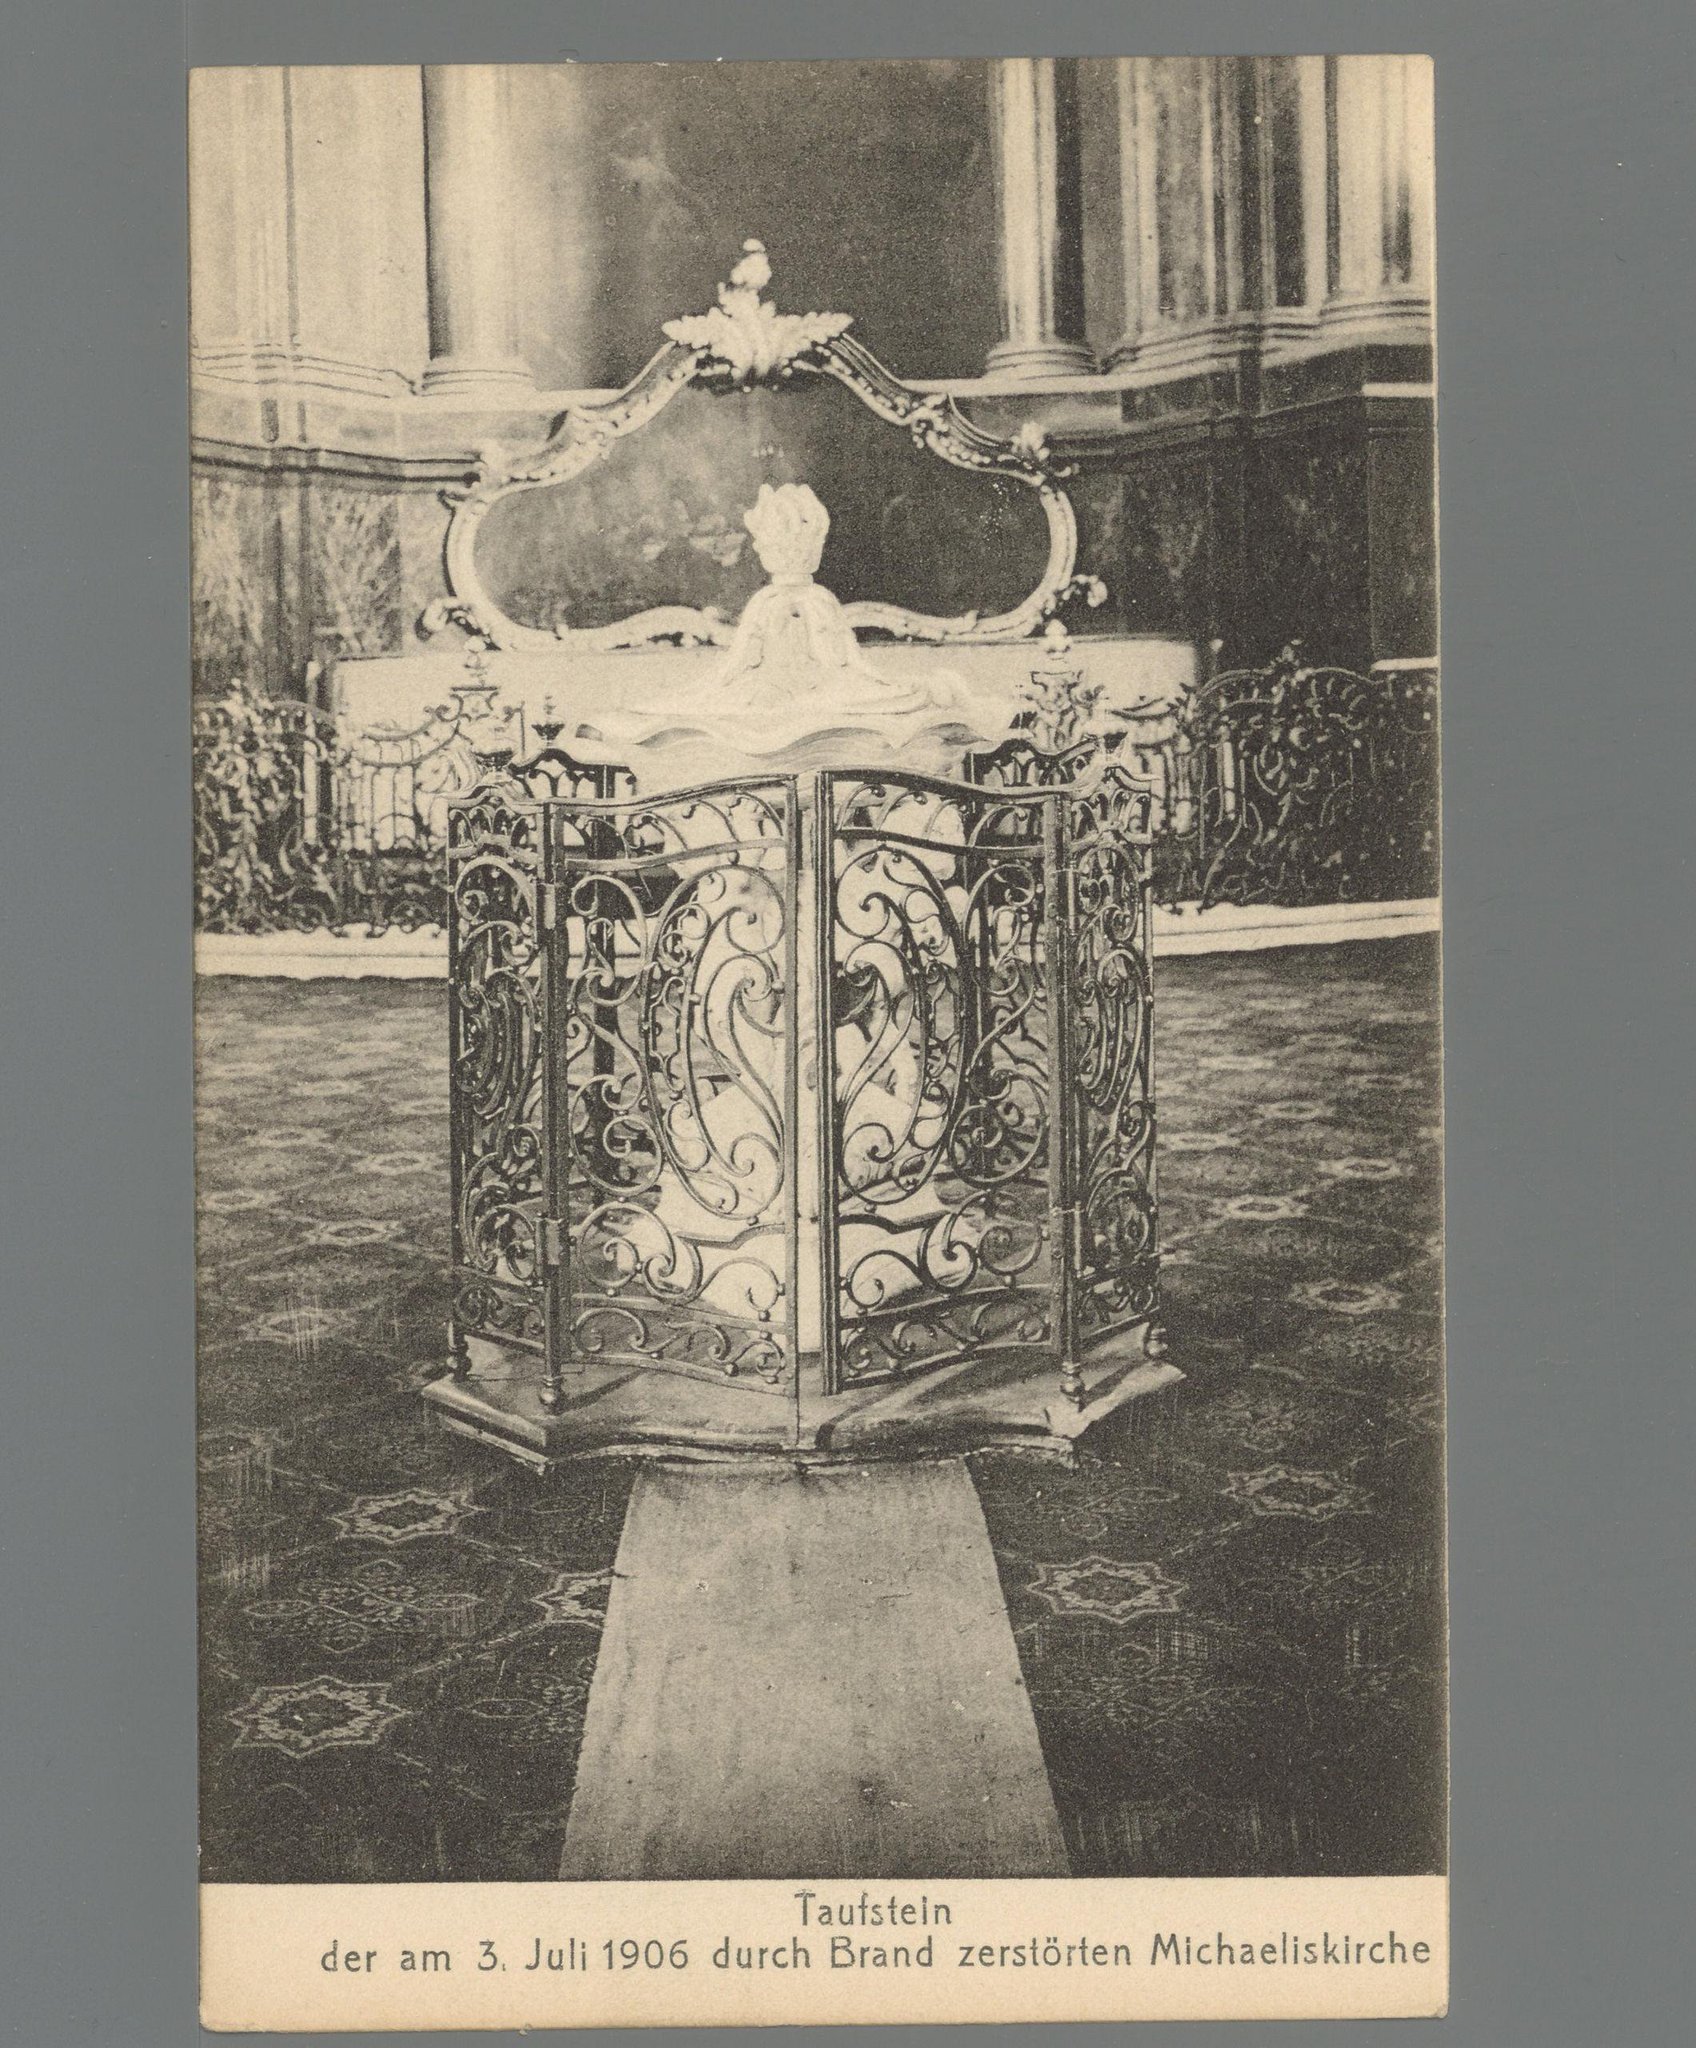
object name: photomechanical print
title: Taufstein der am 3. Juli 1906 durch Brand zerstörten Michaeliskirche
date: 1906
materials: cardboard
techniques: photograph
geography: hamburg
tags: interior of church, baptismal font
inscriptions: date